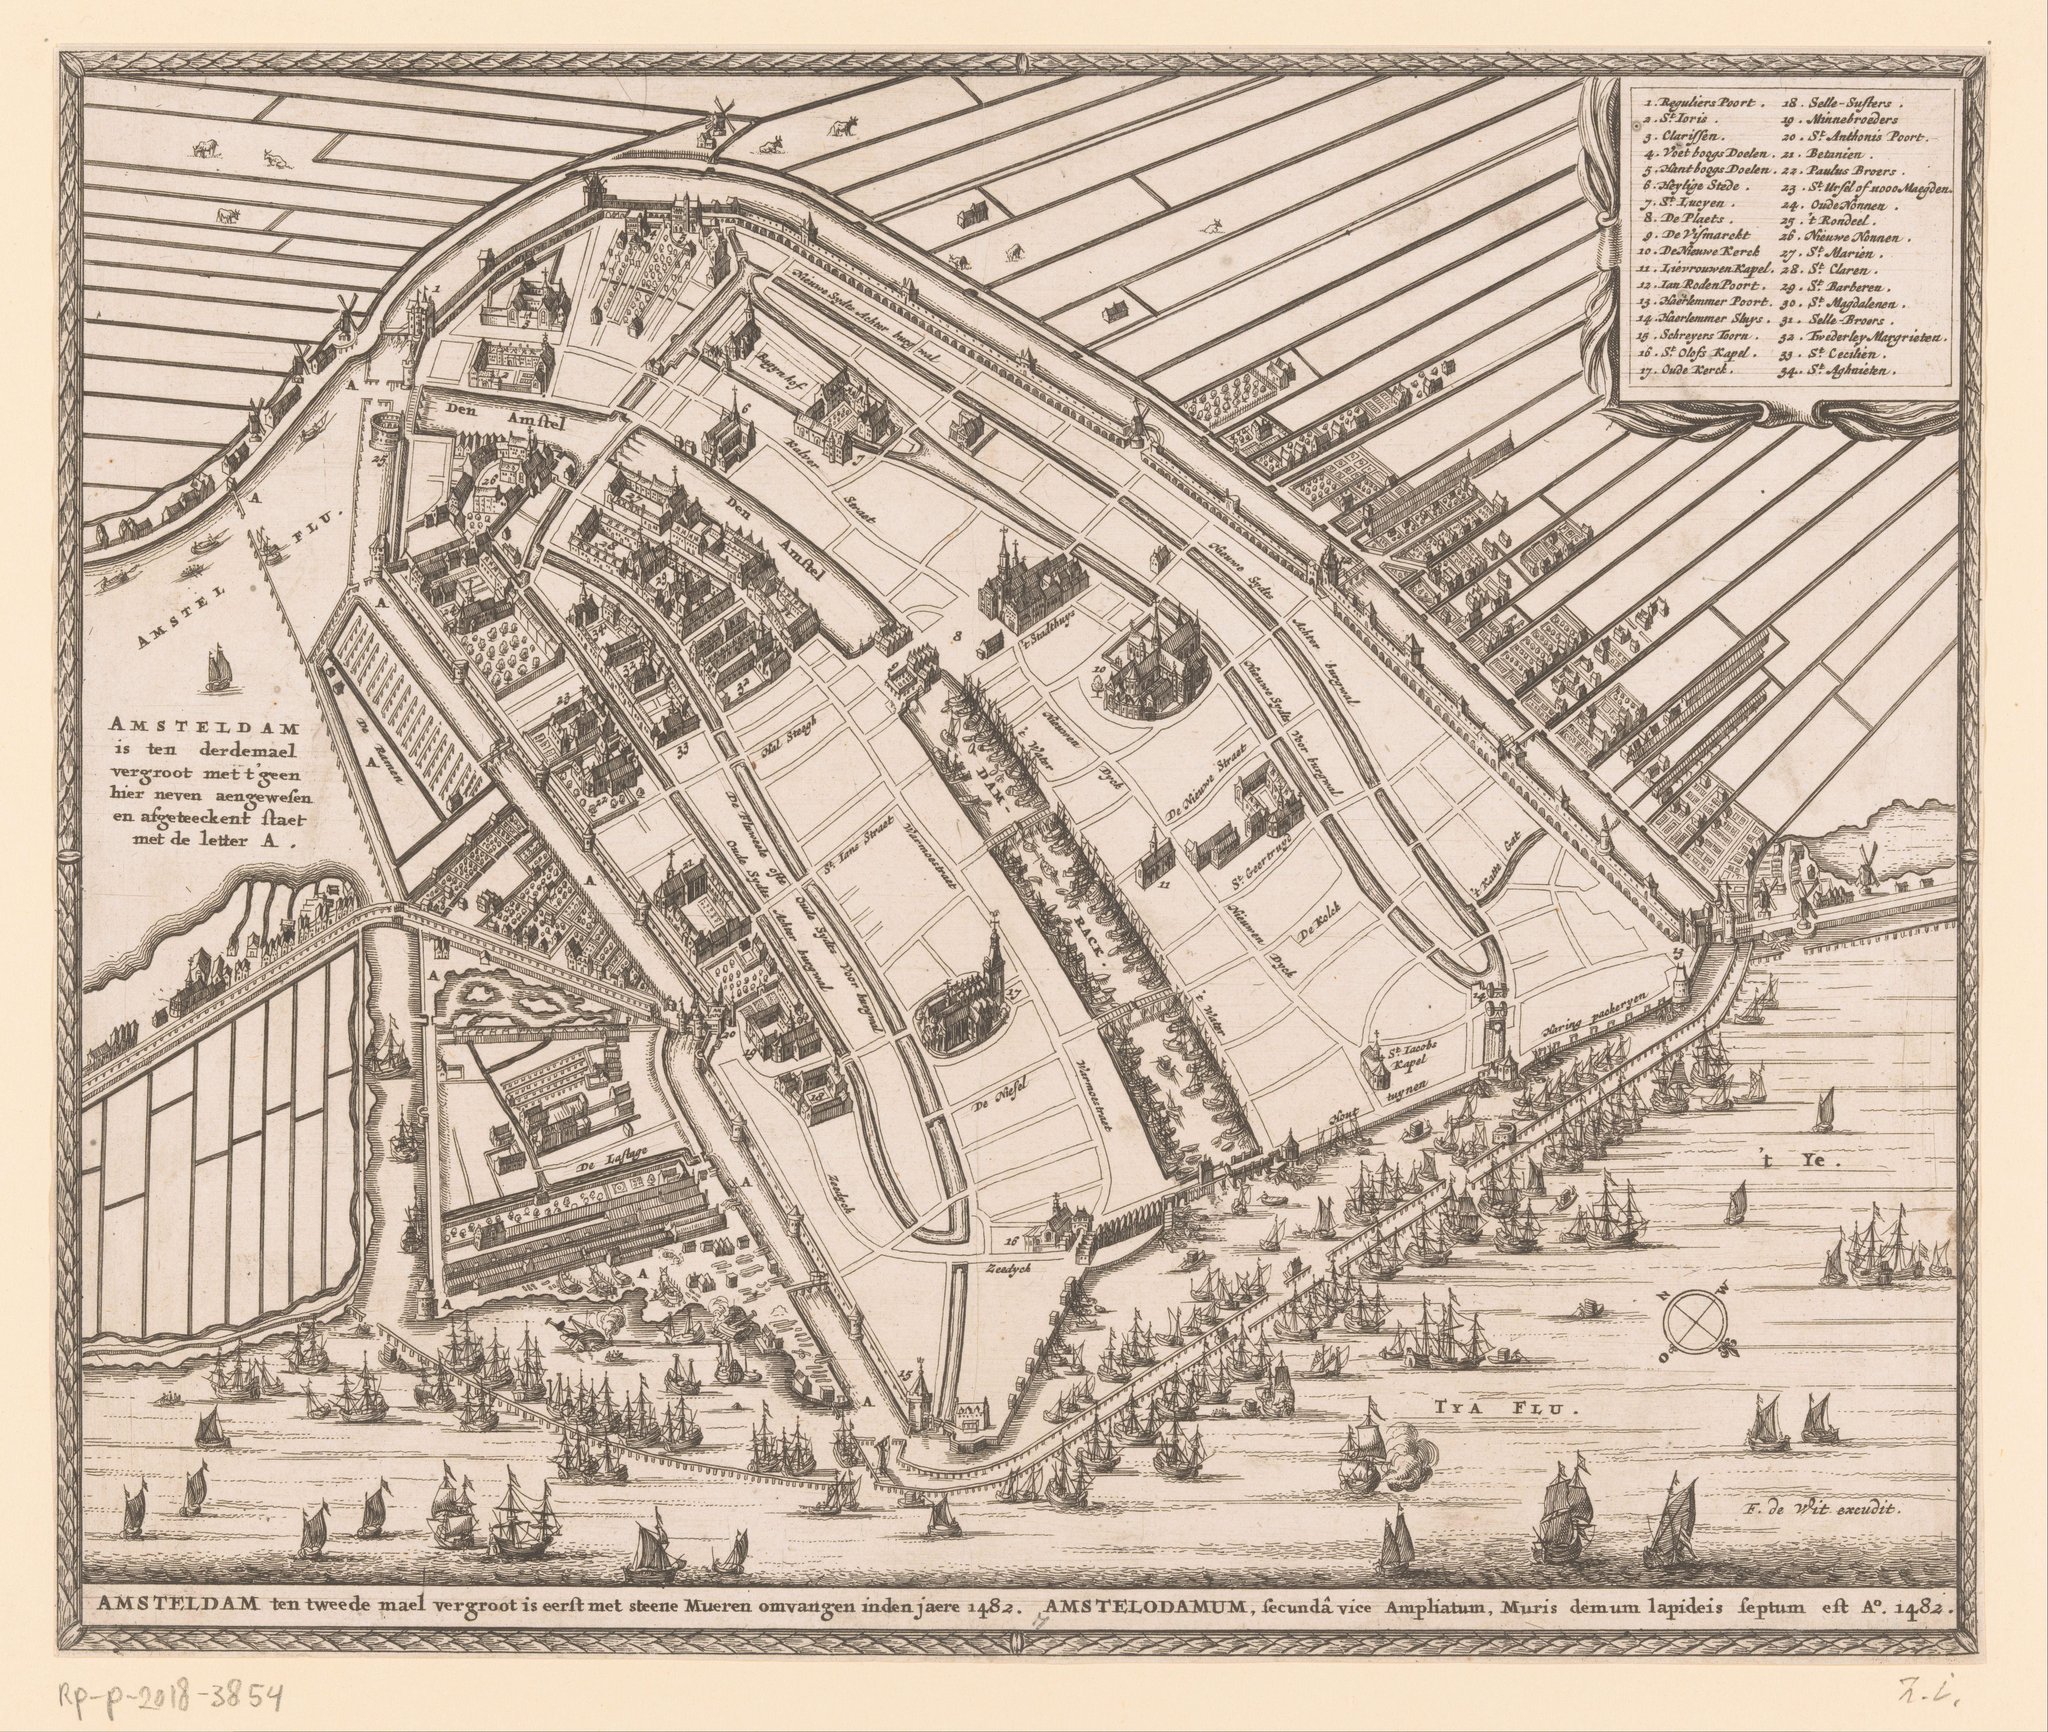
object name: print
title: Plattegrond van Amsterdam, 1482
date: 1671-1680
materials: paper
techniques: engraving, etching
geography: amsterdam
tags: coat of arms (as symbol of the state, etc.) (+ city; municipal), maps of cities, amsterdam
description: Plattegrond van Amsterdam zoals het er na de uitbreiding in 1482 uit zou hebben gezien, in vogelvluchtperspectief. Rechtsboven een cartouche met de legenda 1-34.